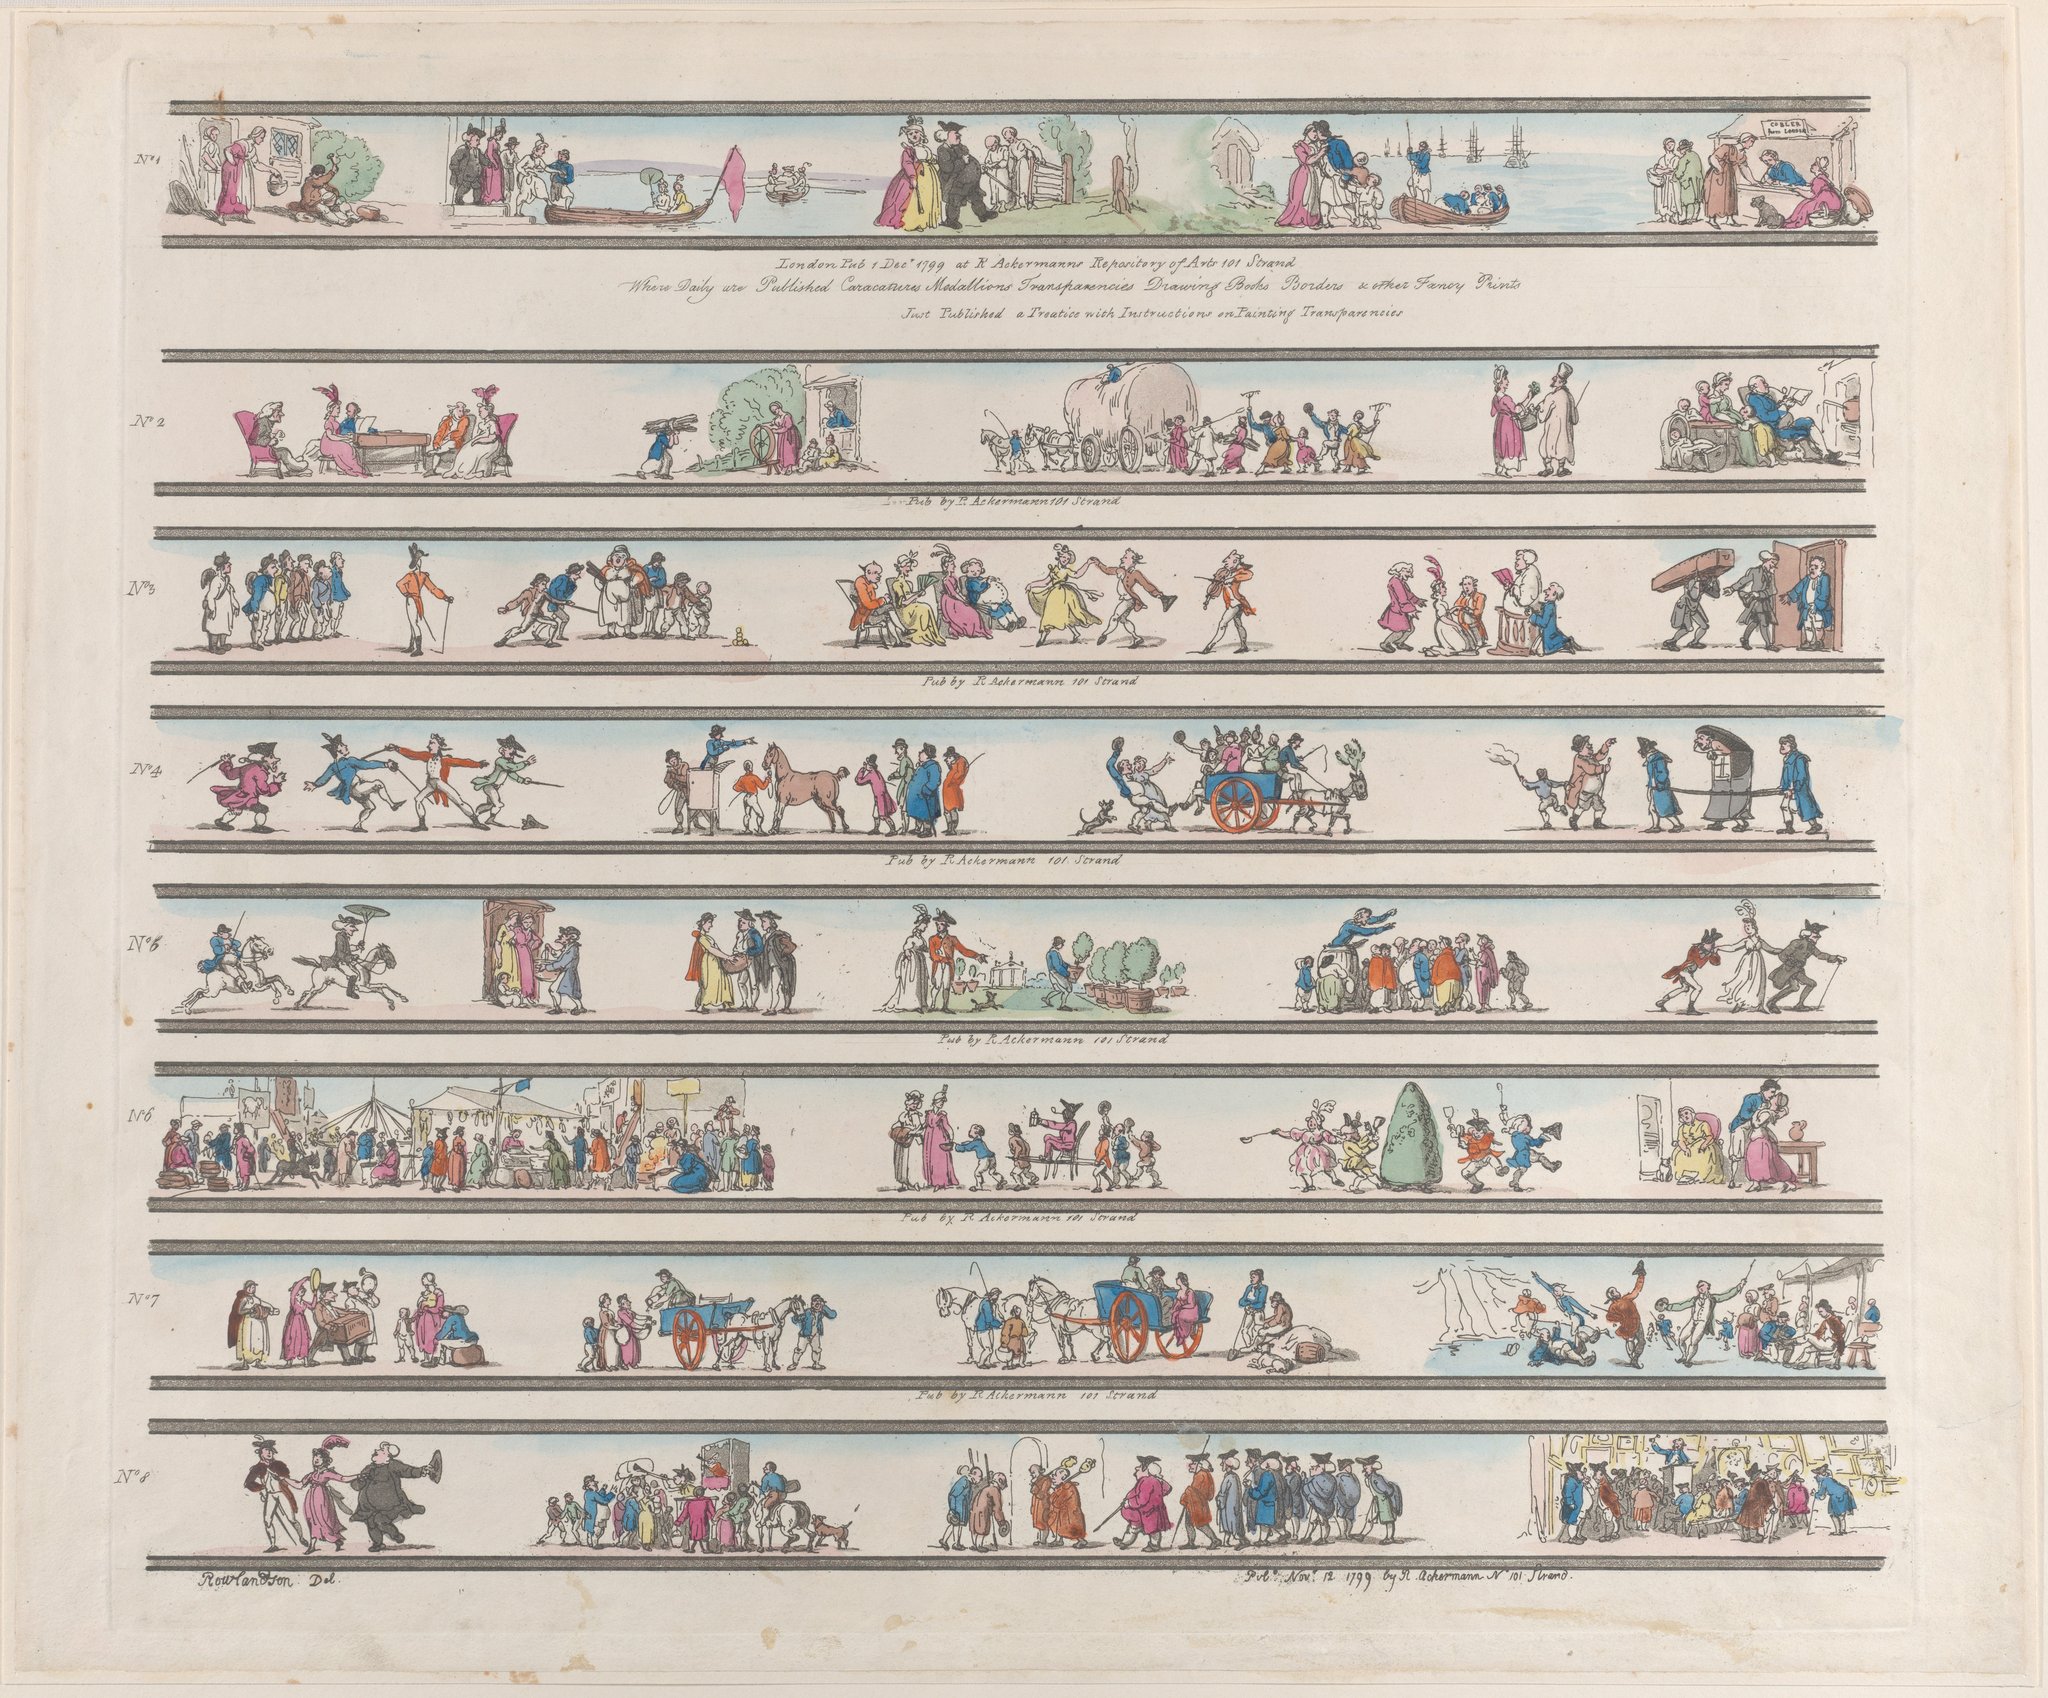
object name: book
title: Rustic Architecture: The Picturesque and Pleasing Appearance of Rough Wood, Thatch, Etc. when Applied as the Only Decorations of Rural Buildings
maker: t. j. ricauti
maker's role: architect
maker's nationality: british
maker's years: 1800-1900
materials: zinc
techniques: lithograph, lithography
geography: england